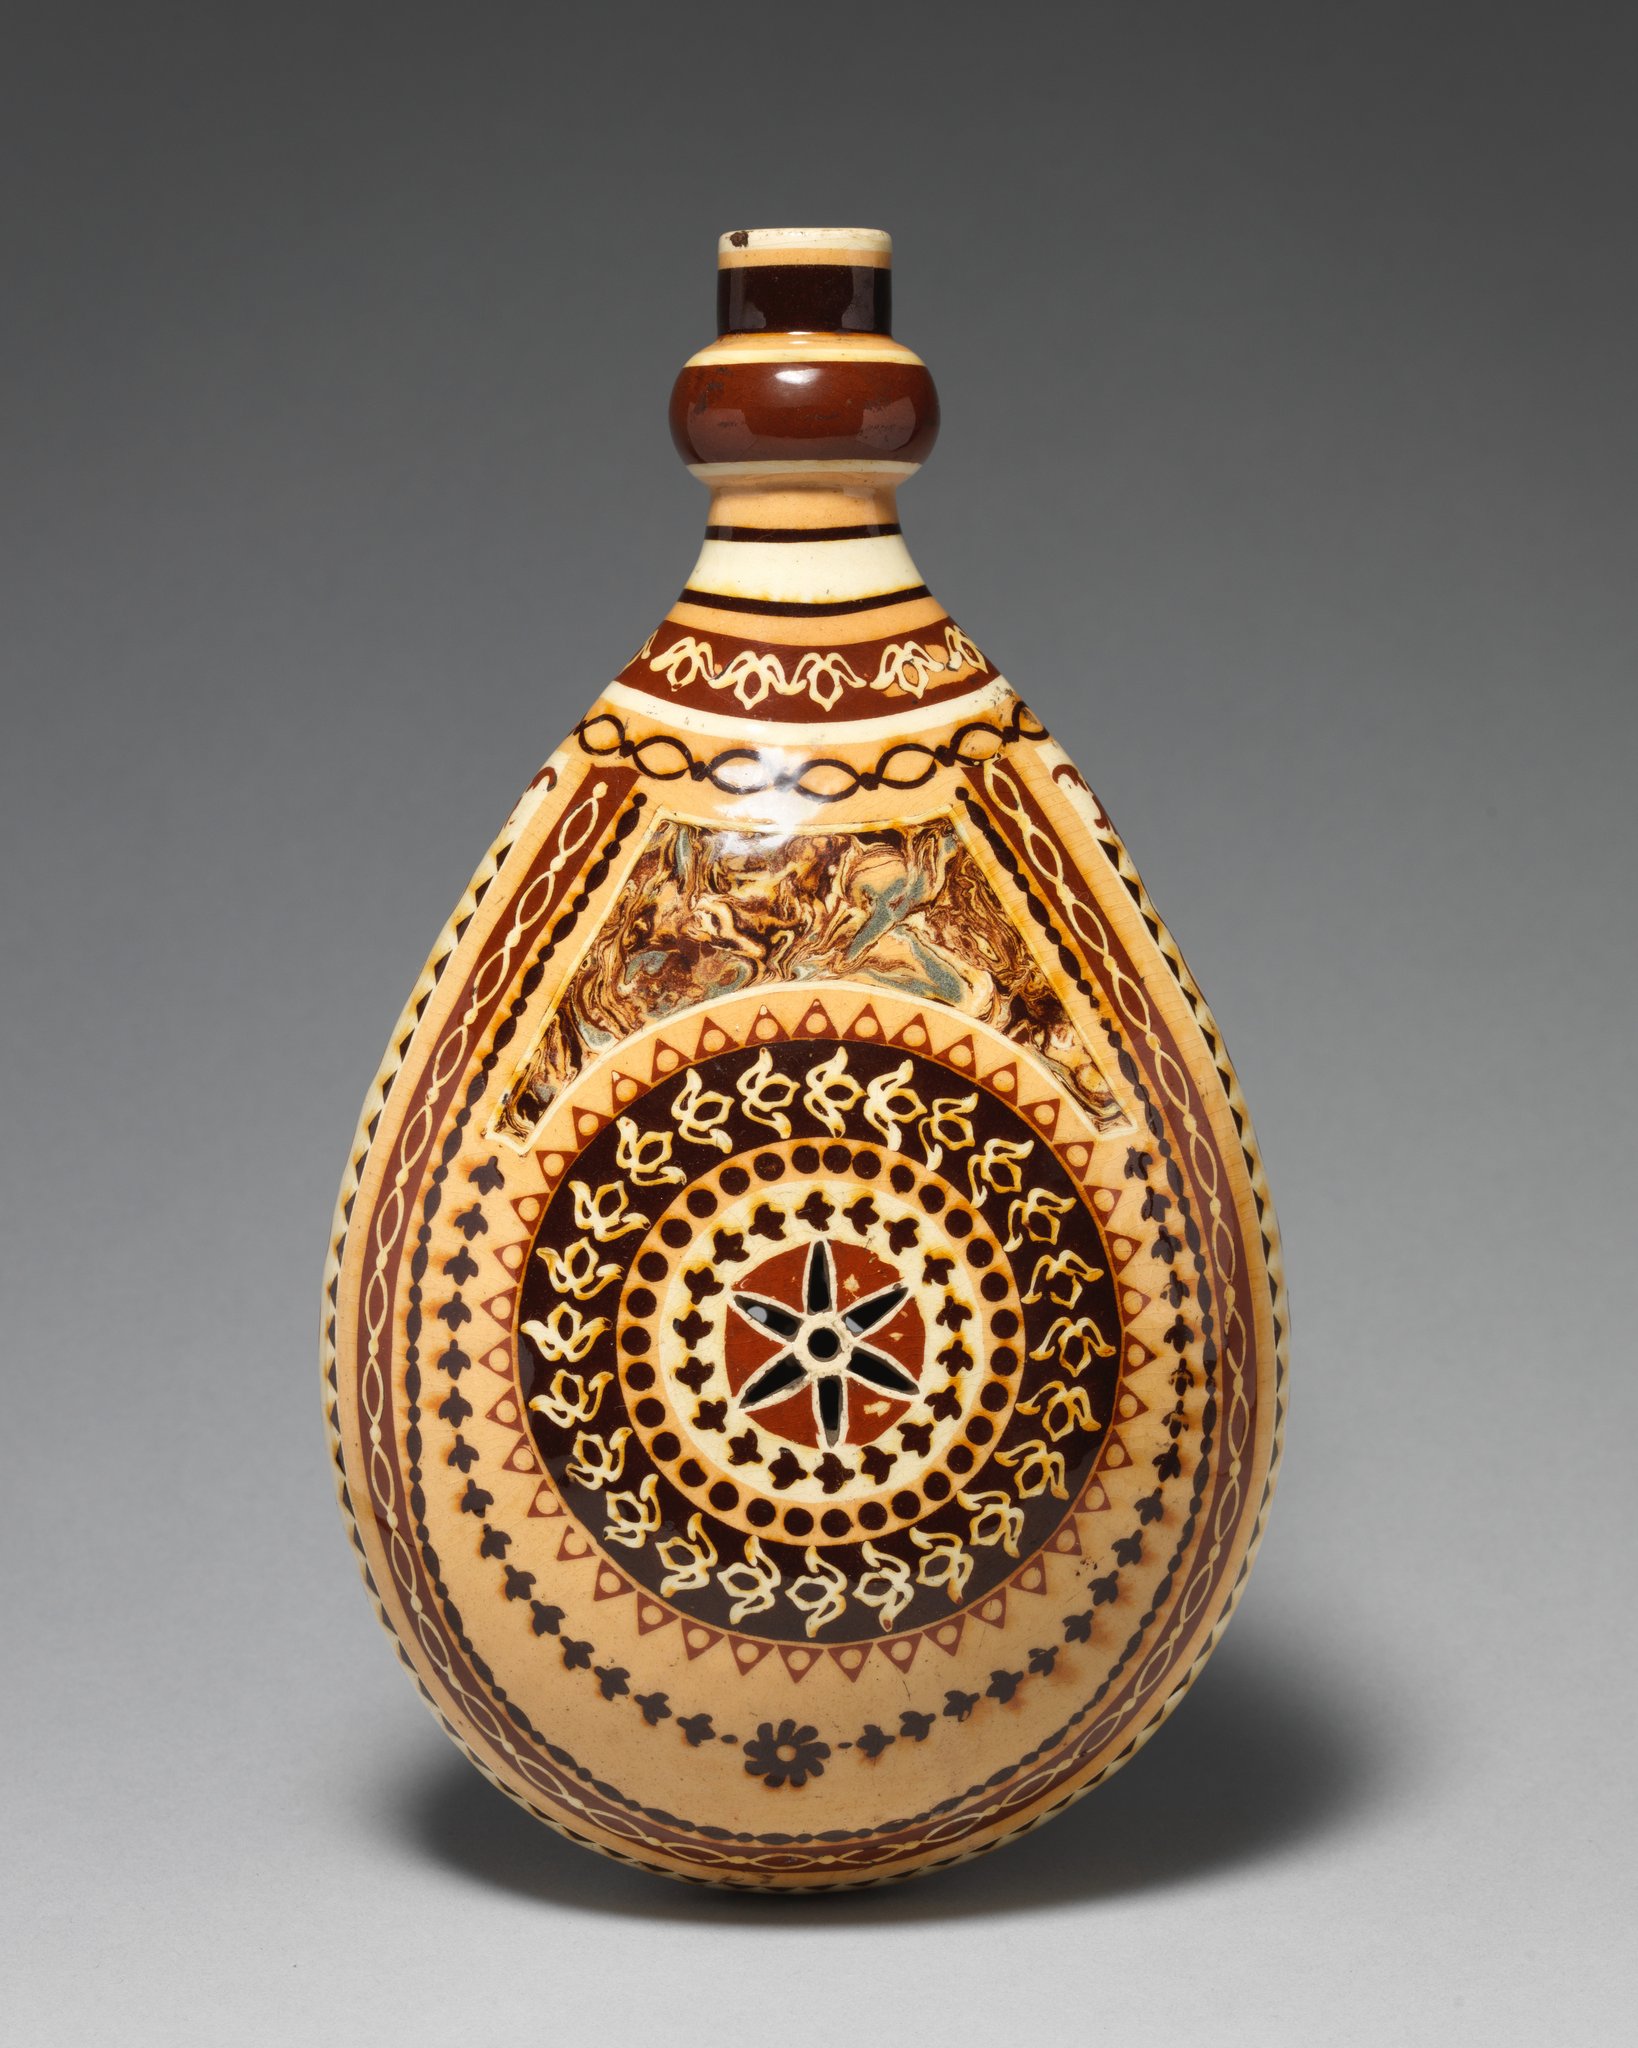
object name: flask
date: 1701-1800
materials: faience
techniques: glazing